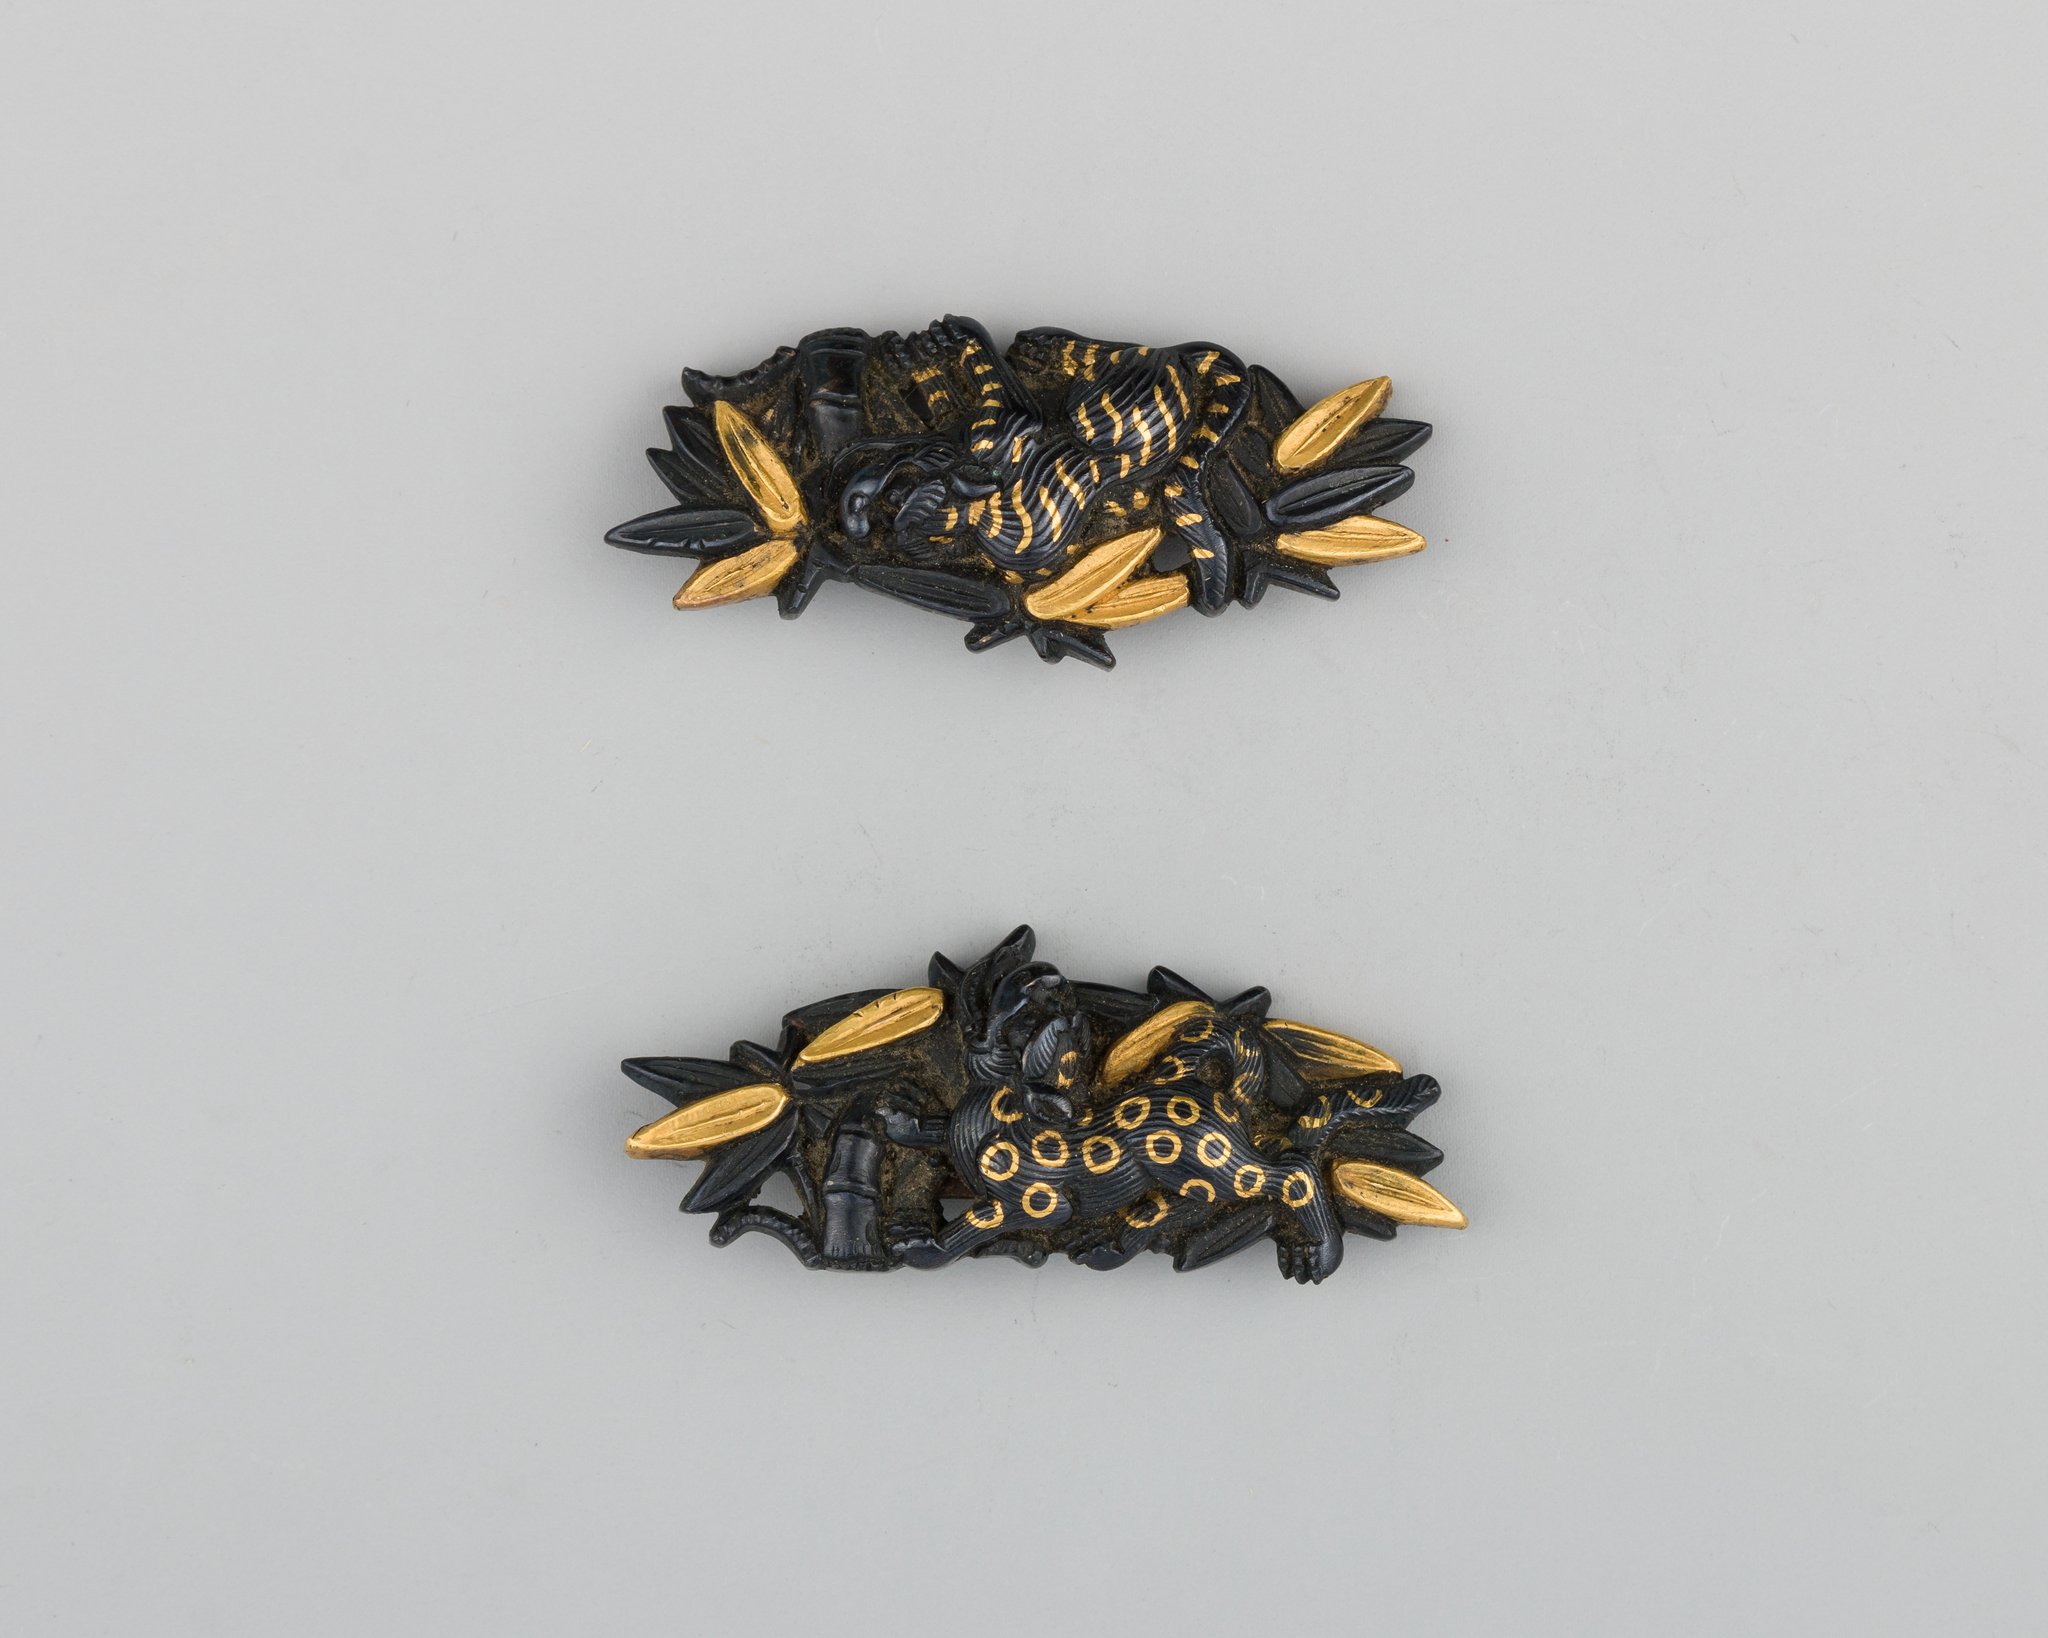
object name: pair of sword grip ornament menuki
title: Pair of Sword-Grip Ornaments (Menuki)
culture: japanese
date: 1601-1700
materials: gold alloy, gold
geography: japan